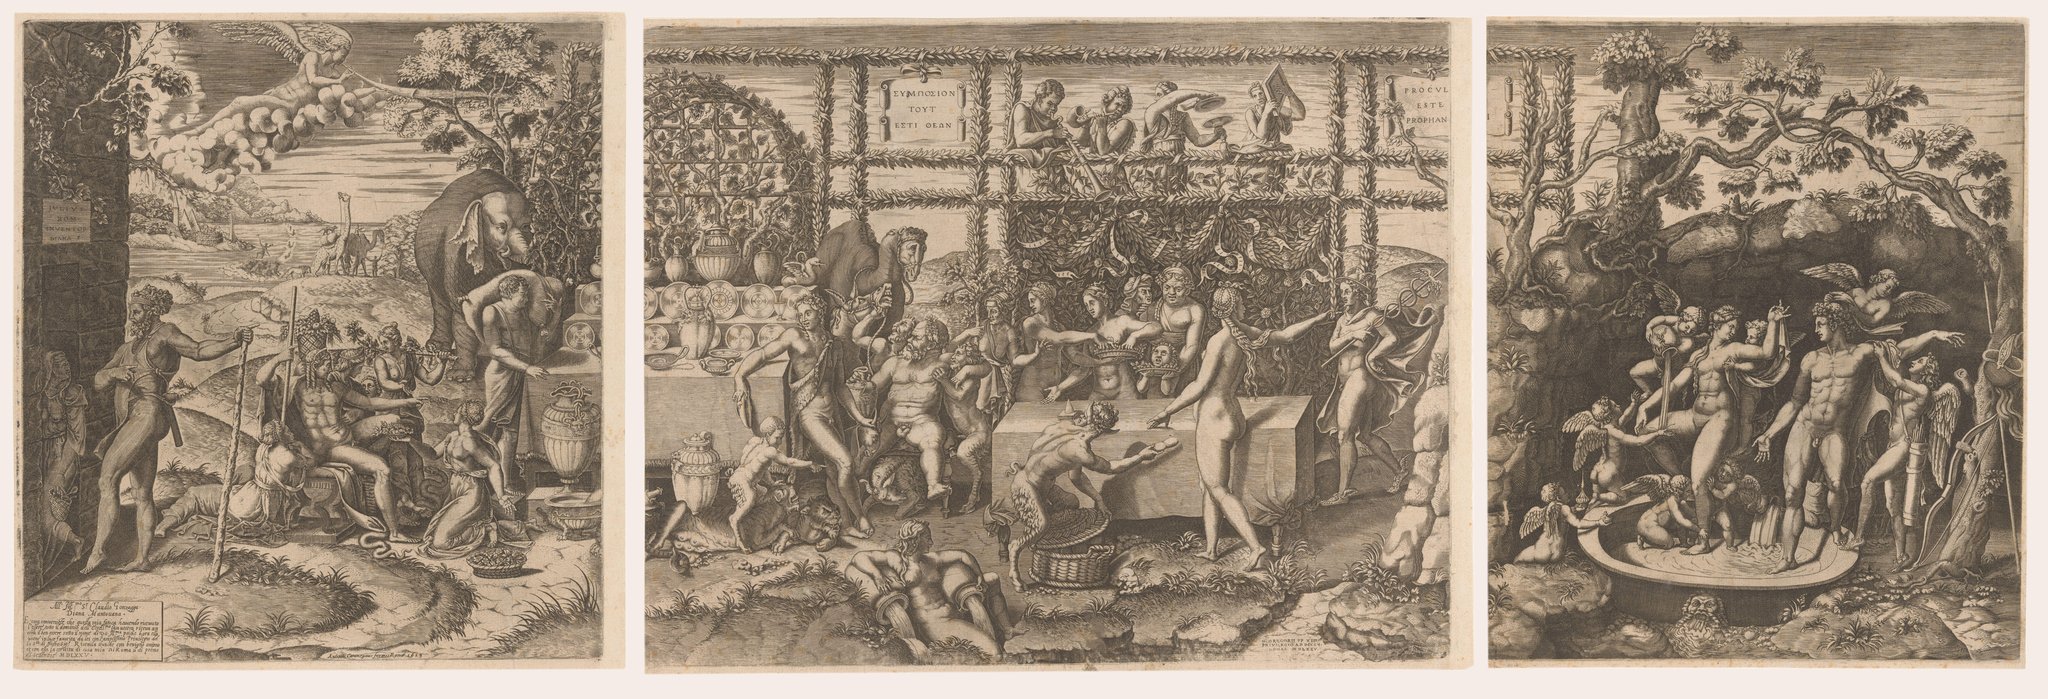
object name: print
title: Voorbereidingen voor het huwelijksfeest van Amor en Psyche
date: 1575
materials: paper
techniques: engraving, etching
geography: italy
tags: (story of) bacchus (dionysus), liber, (story of) mercury (hermes), marriage of cupid and psyche, bath of venus and mars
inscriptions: collector's mark: ‘Hinloopen’, collector's mark: Lugt 10, collector's mark: Lugt 11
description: Door verscheidene mythologische figuren wordt het huwelijksfeest van Amor en Psyche voorbereid. Links zit Apollo omringd door godinnen. In het midden een met luxe serviesgoed gedekte tafel en een tweede tafel met daaromheen Bacchus, saters, Mercurius en de gratiën. Rechts in een bassin voor een grot worden een god en godin, mogelijk Mars en Venus, door putti gewassen.